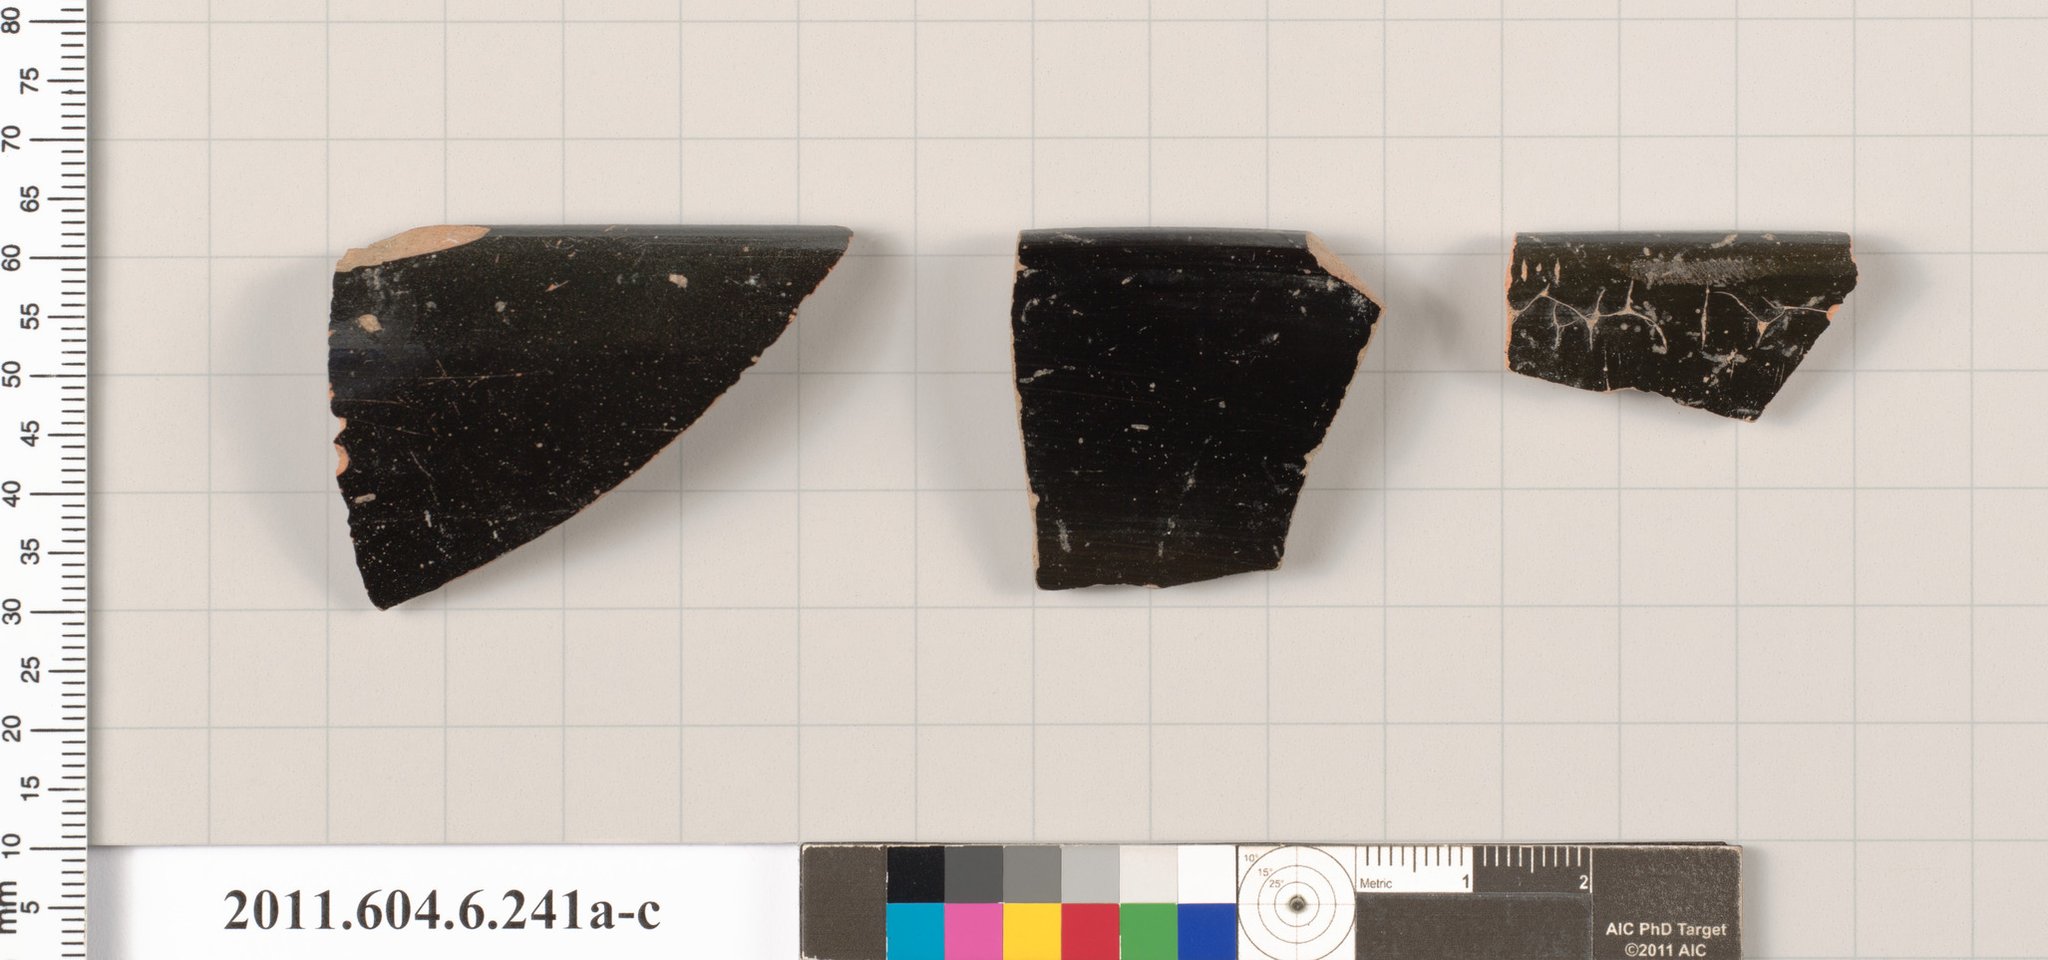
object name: fragment of a bowl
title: Terracotta rim fragments of bowls?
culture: greek, attic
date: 500-301 BCE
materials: terracotta